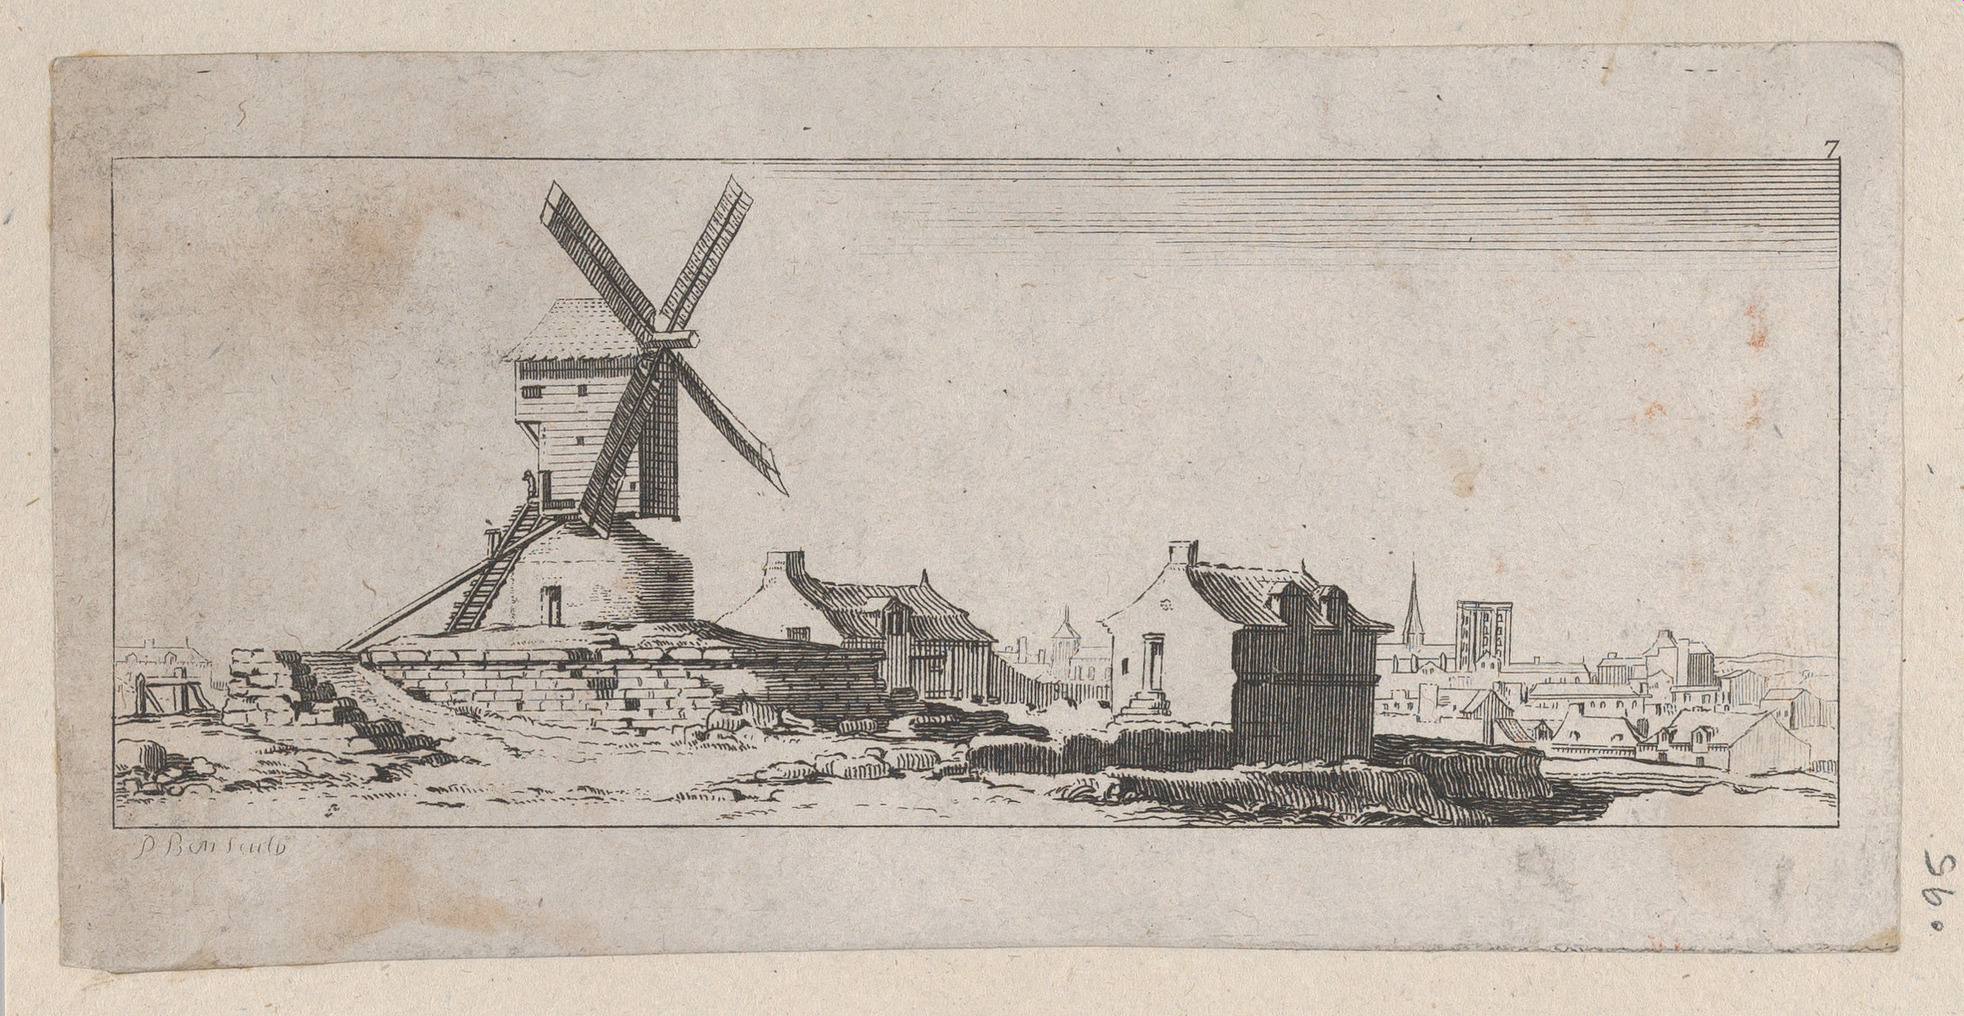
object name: print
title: View of a Windmill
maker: p. benoist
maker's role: artist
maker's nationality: french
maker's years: 1600-1700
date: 1701-1800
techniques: engraving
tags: windmills